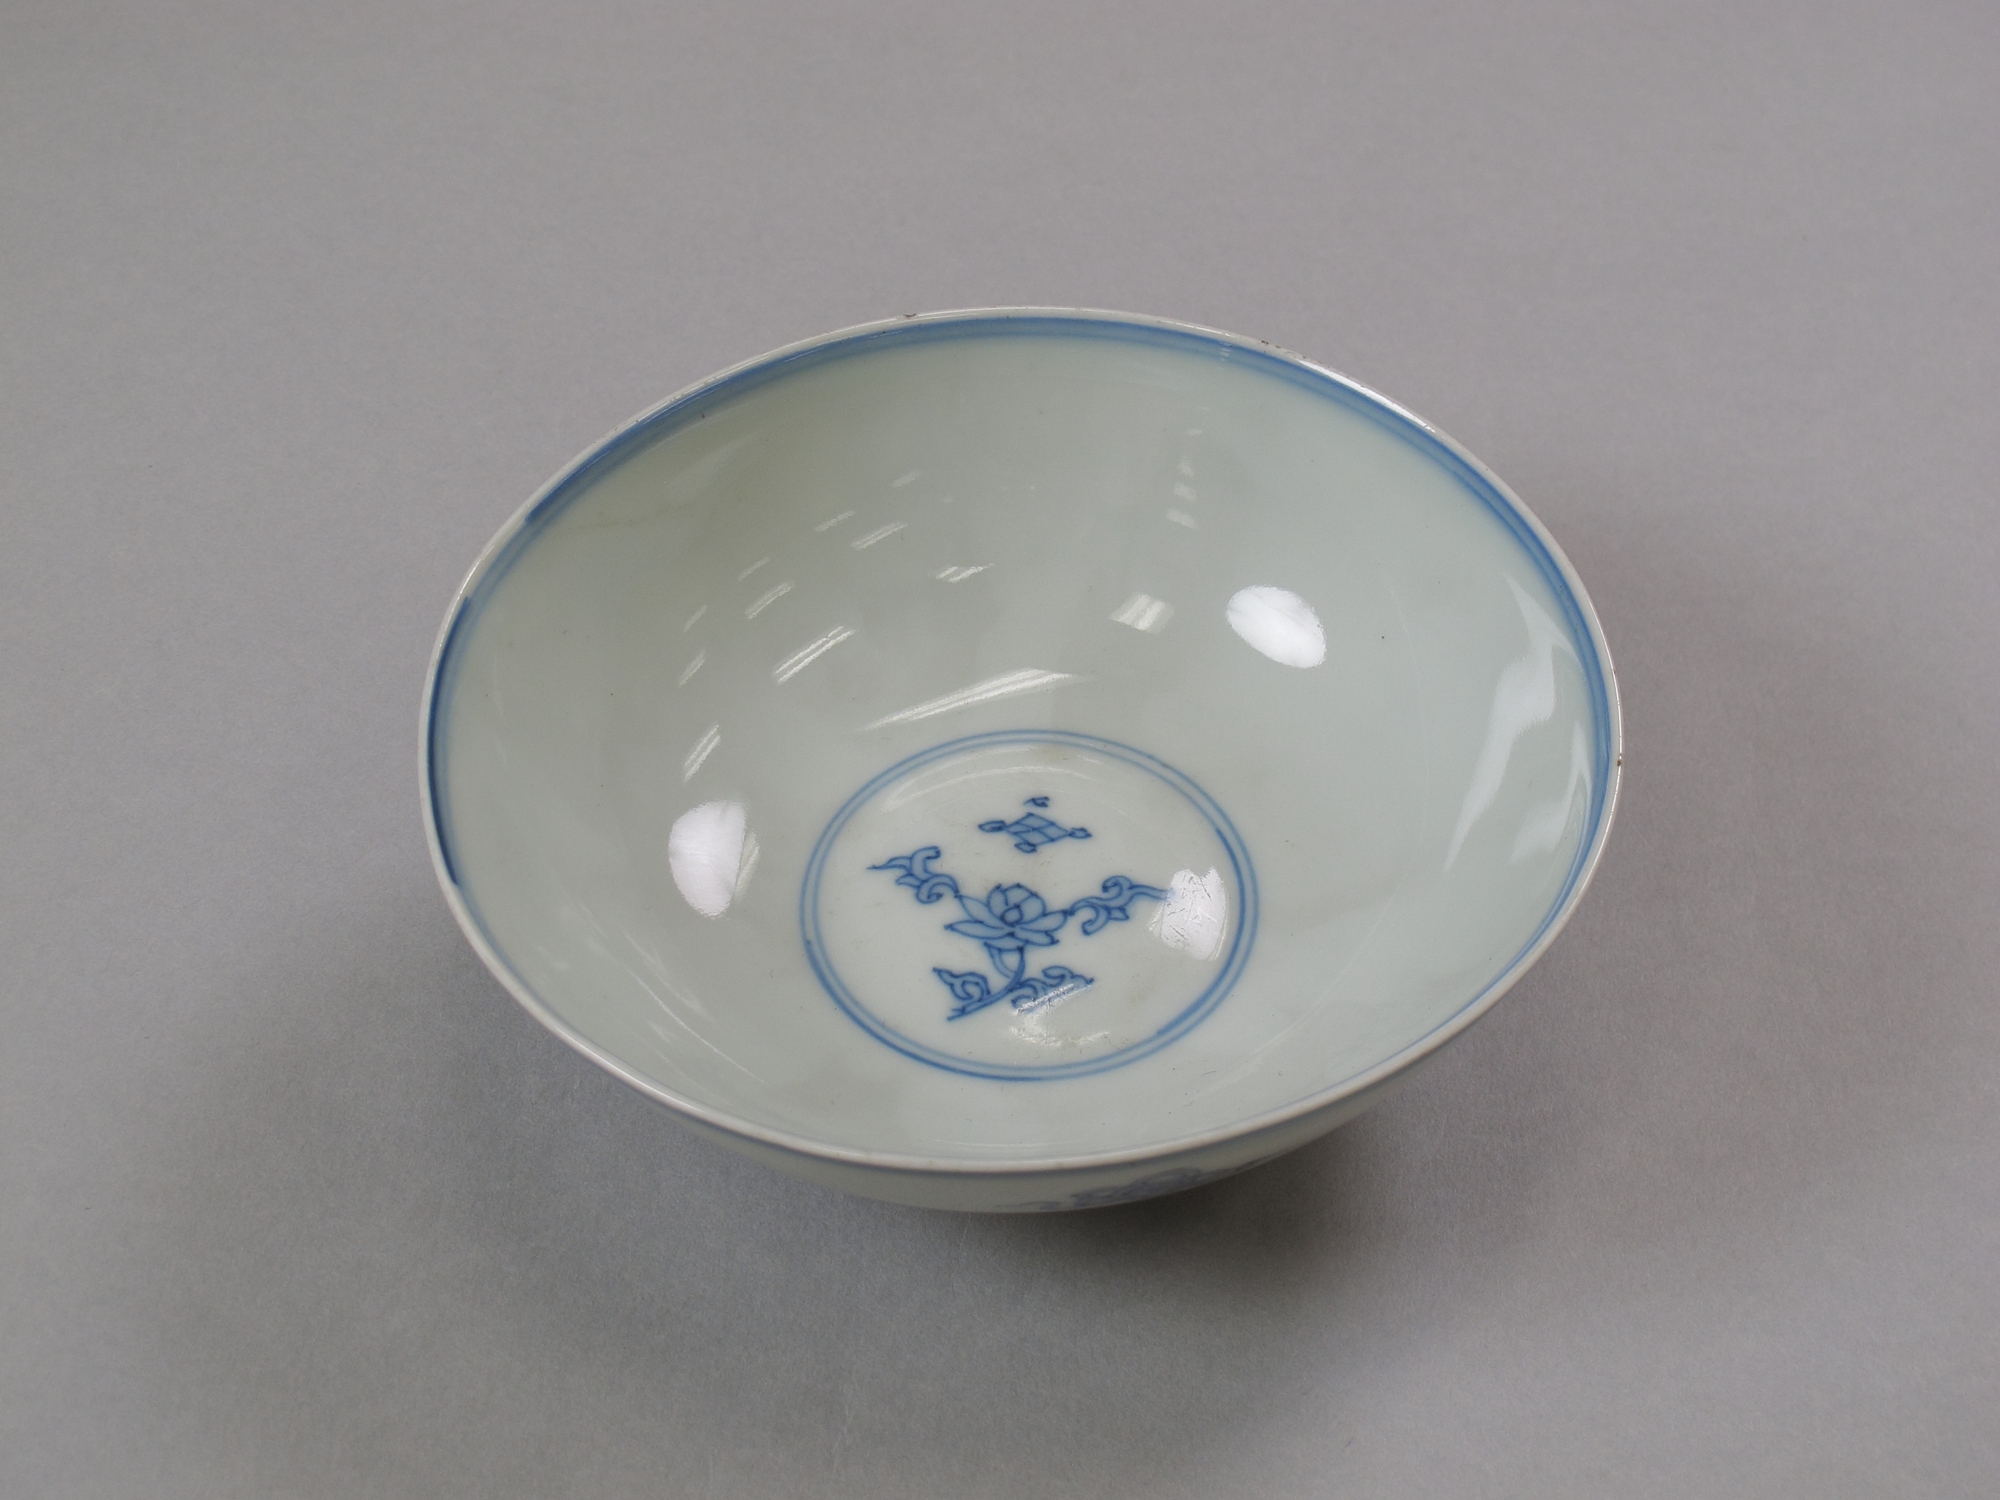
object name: bowl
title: Bowl with Eight Buddhist Treasures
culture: chinese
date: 1601-1633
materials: cobalt, porcelain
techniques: painting, underglaze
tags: lotuses